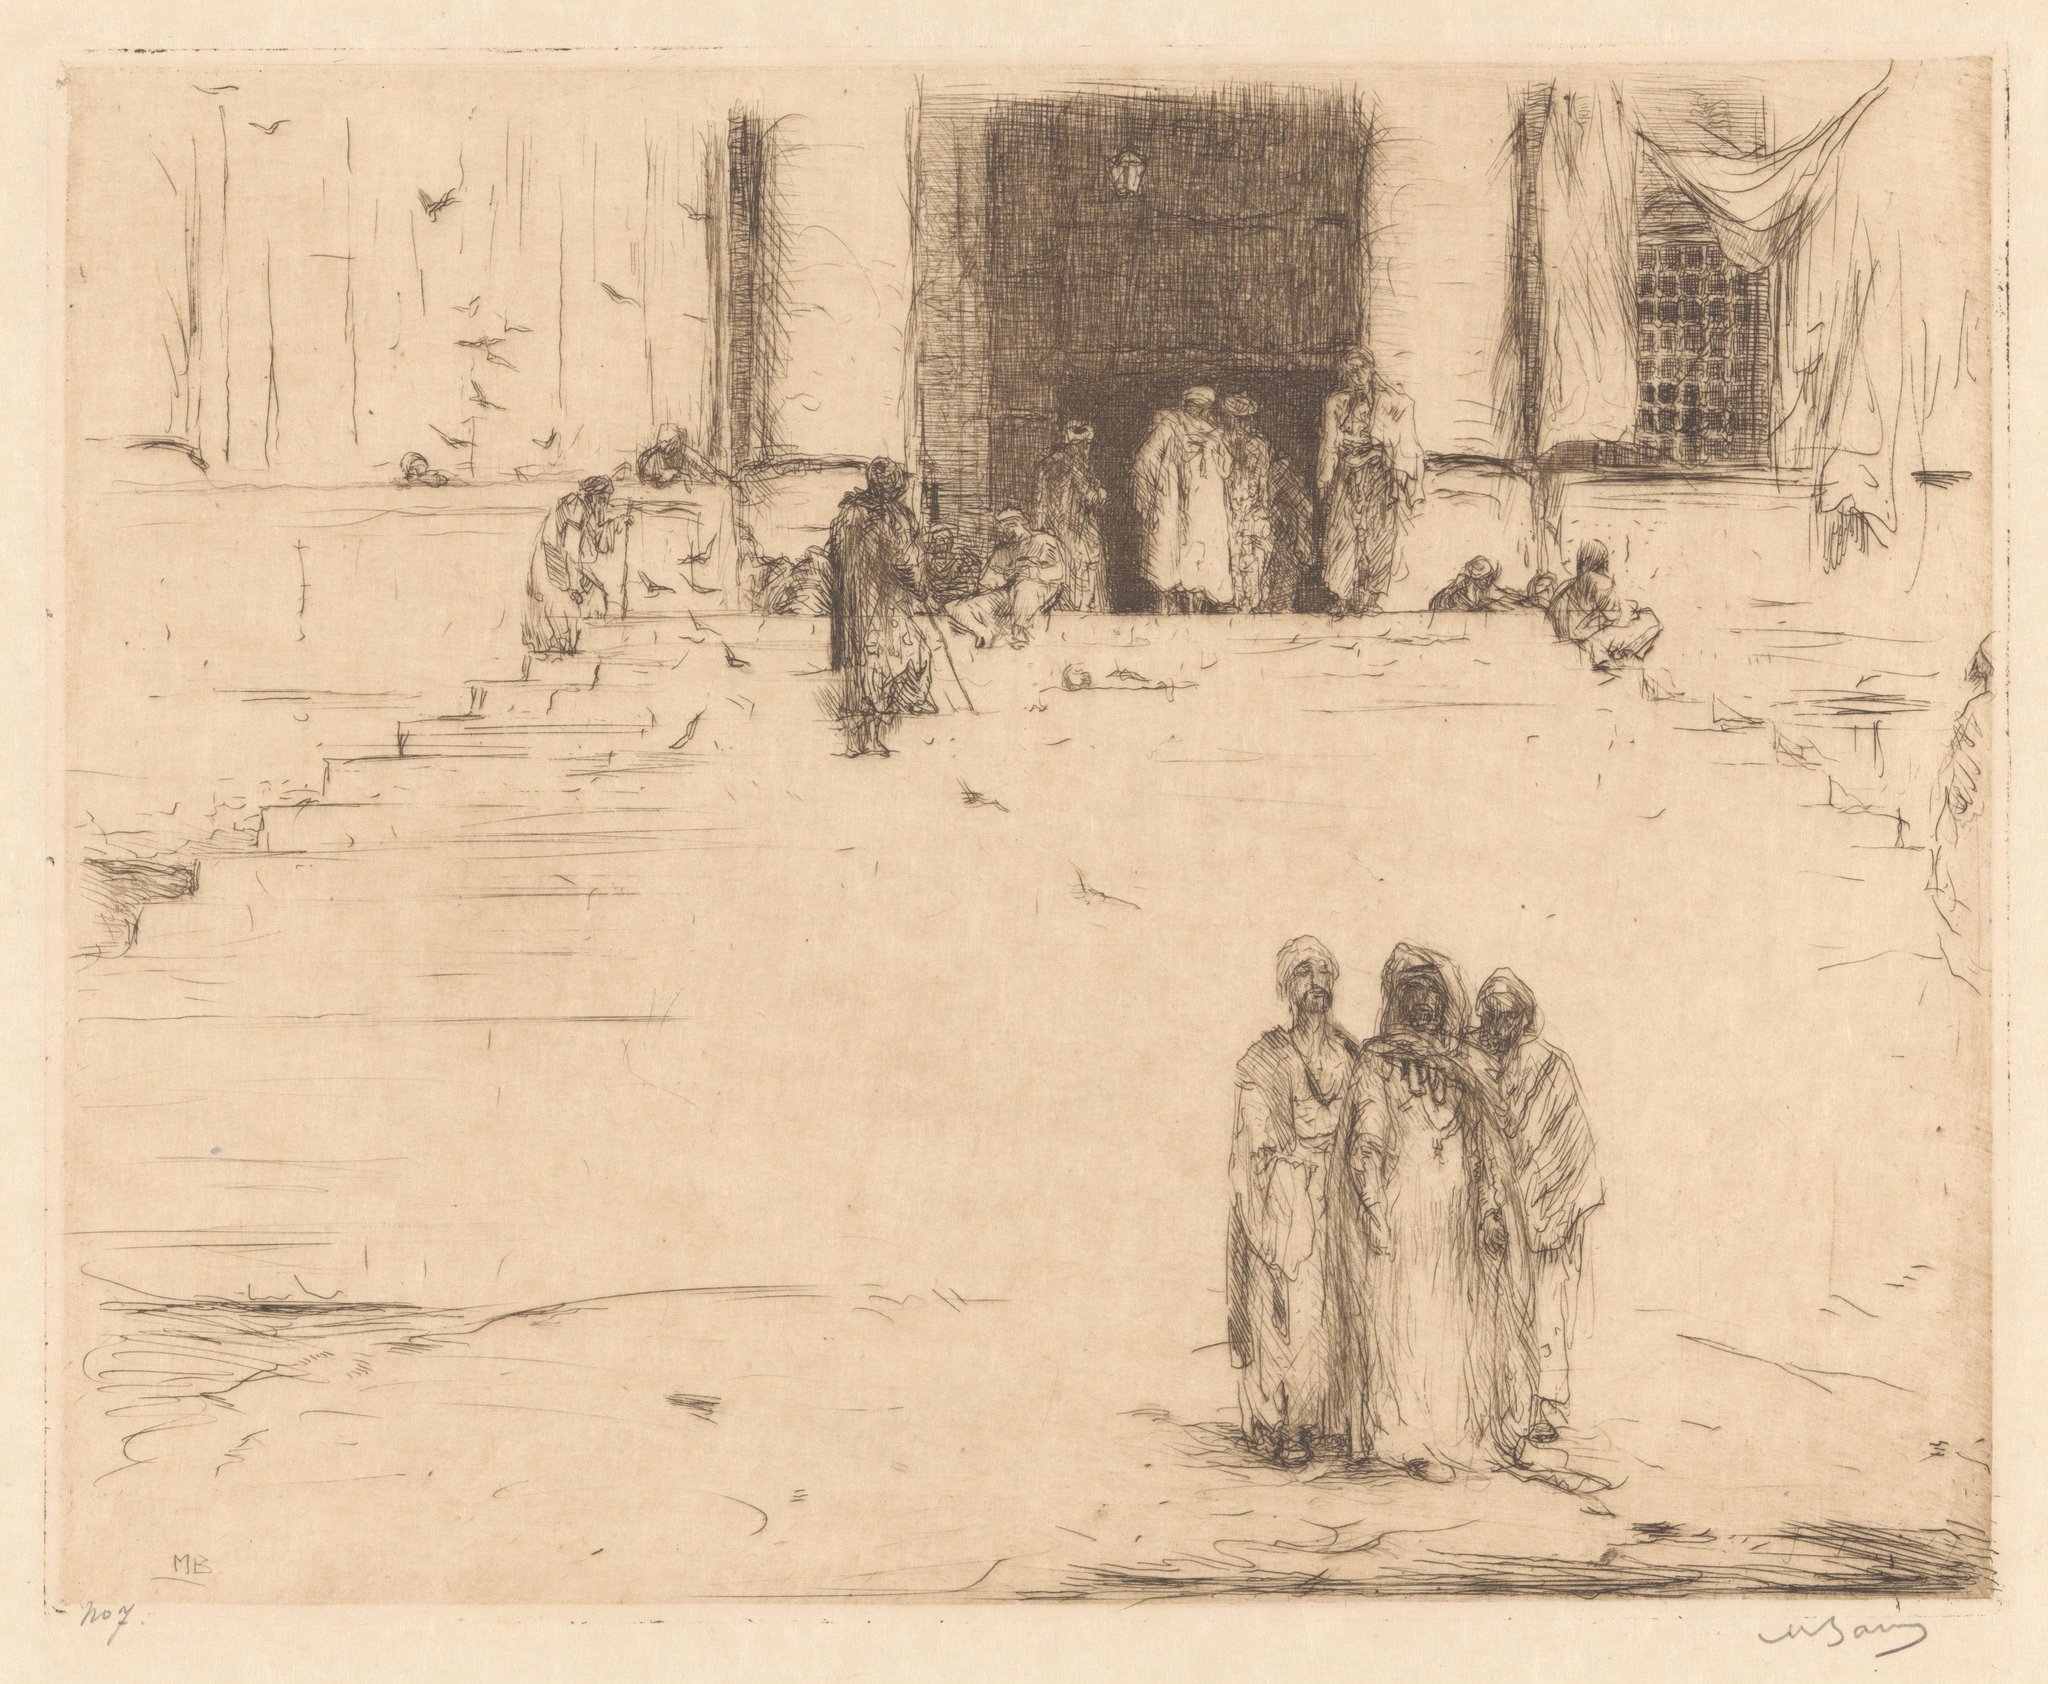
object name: print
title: Figuren voor een moskee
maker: marius bauer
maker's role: draughtsman, print maker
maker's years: 1867-1932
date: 1922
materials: paper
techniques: etching, intaglio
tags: temple, shrine ~ islam, mohammedanism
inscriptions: collector's mark: Lugt 2228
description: Figuren voor en op een trap die leidt naar de ingang van een moskee.